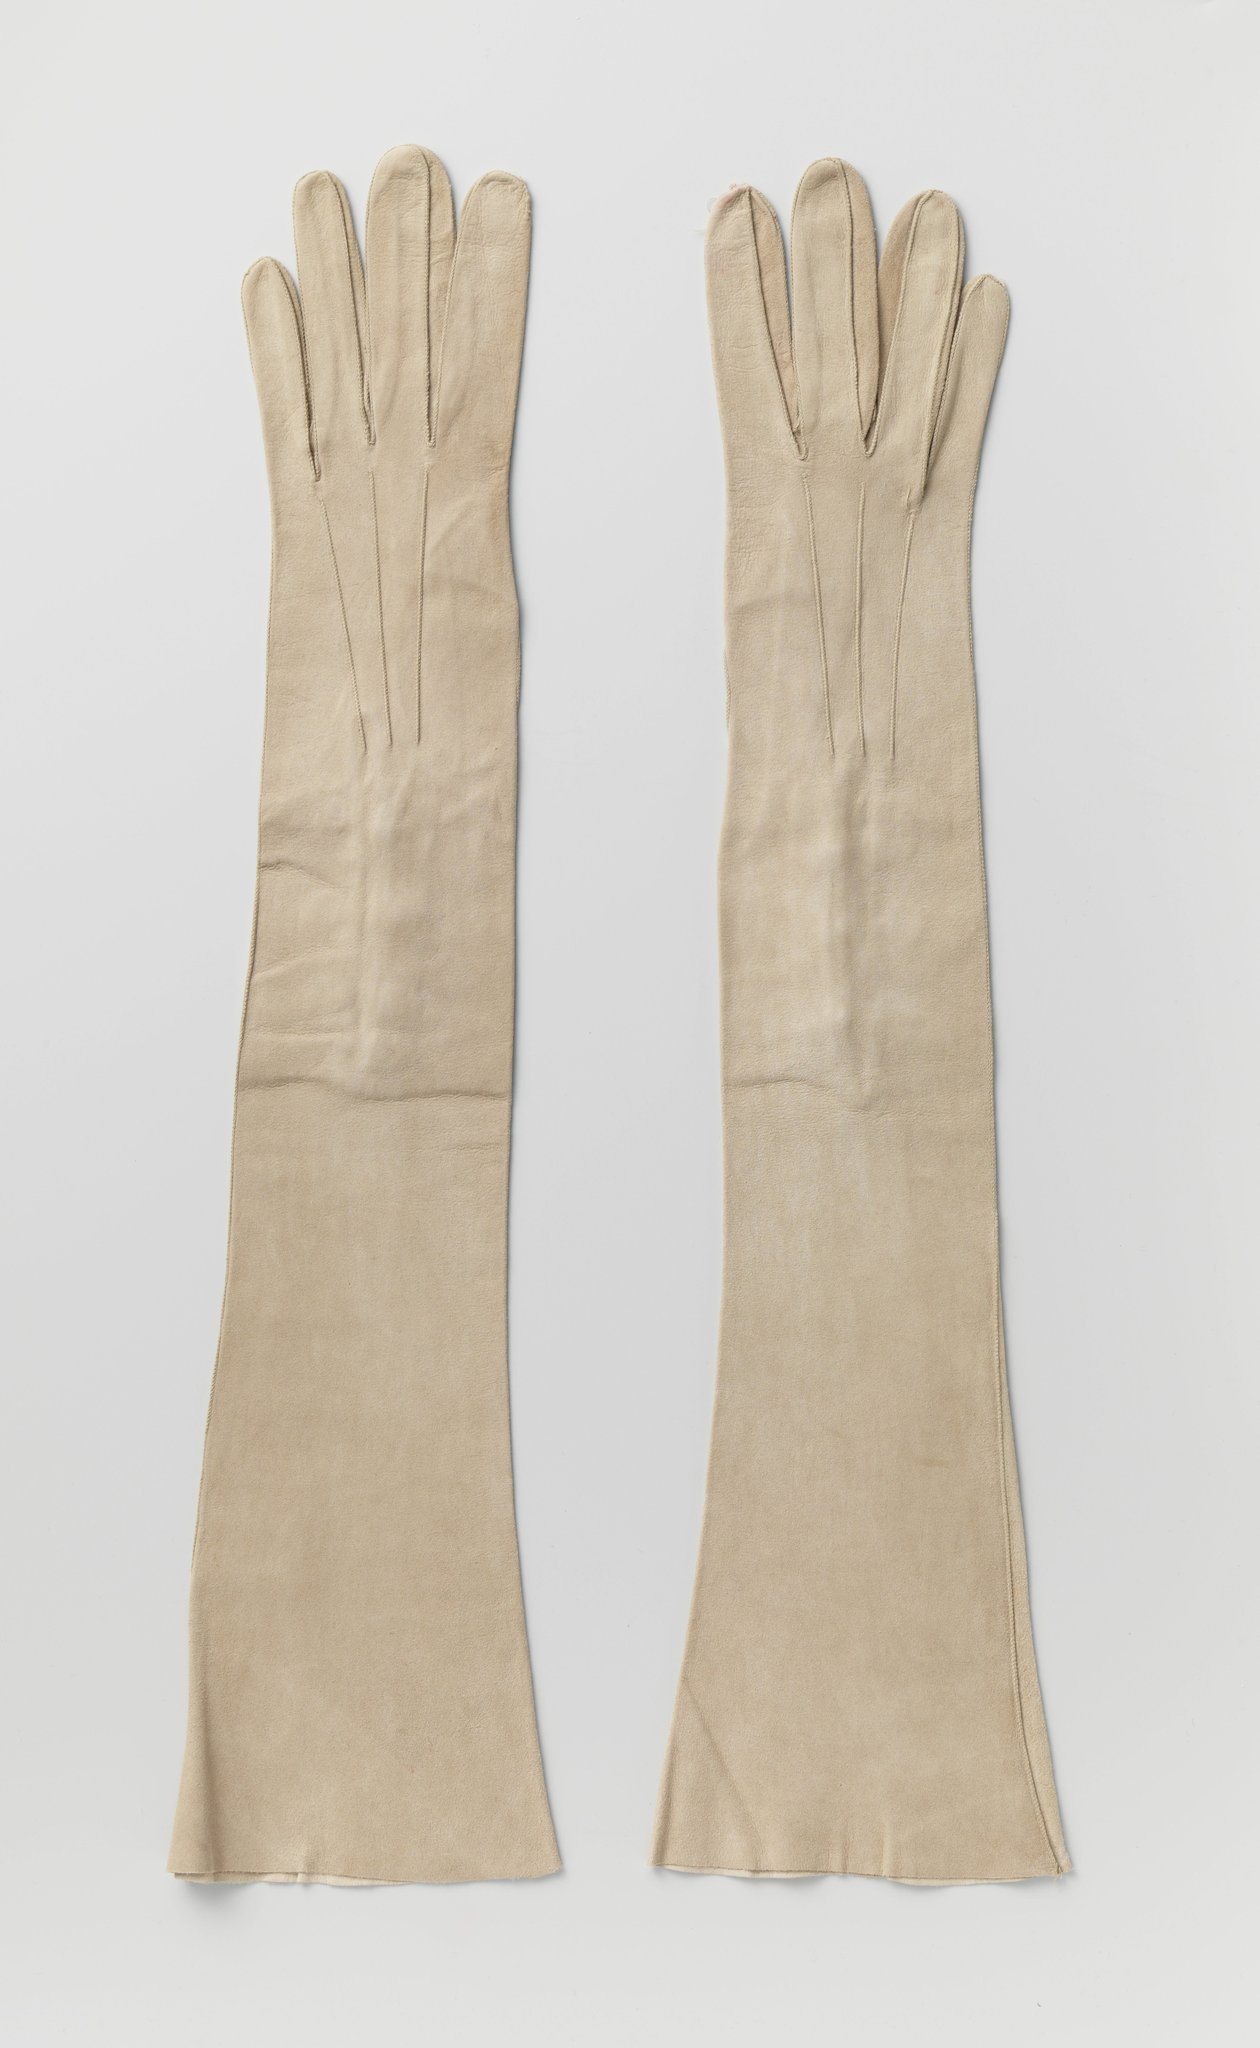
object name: clothing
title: Handschoen van leverkleurig zeemleer en drie kunsstof knopen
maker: Anonymous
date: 1900-1915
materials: leather, plastic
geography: western europe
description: Linker handschoen van leverkleurig zeemleer, bij de pols een split met drie kunsstof witte parelmoeren kunsstof knopen, op de rug drie uitstralende koorden.